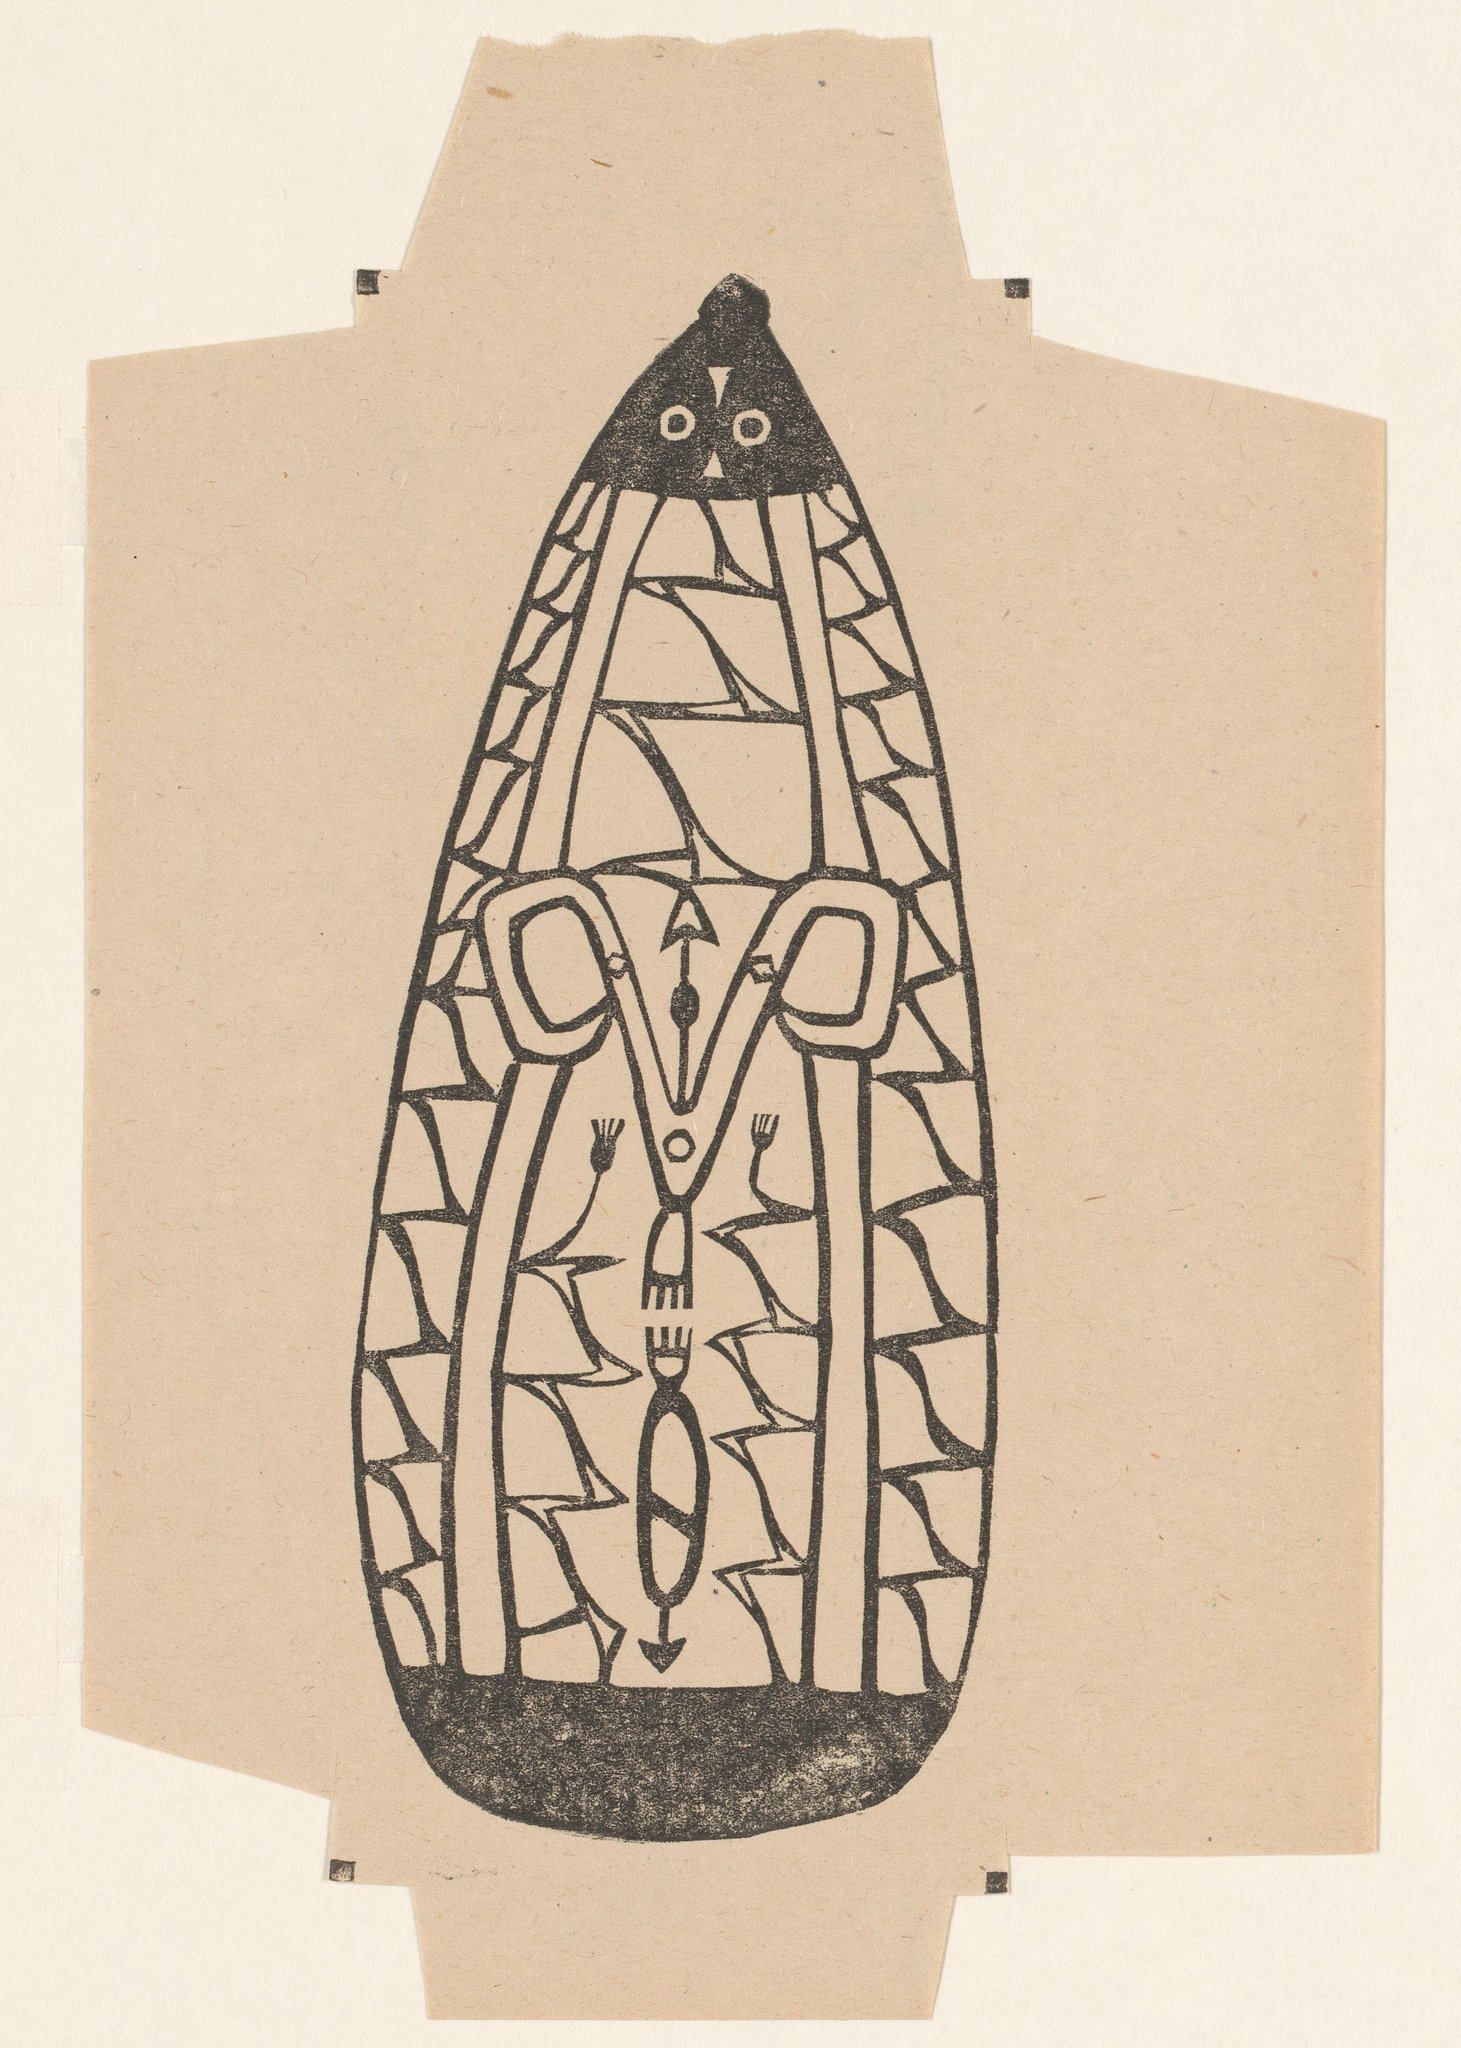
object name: print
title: Schild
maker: reijer stolk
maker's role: draughtsman, print maker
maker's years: 1896-1945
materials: paper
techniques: woodcut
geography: netherlands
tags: protective weapons: shield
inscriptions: collector's mark: Lugt 2228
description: Langwerpig schild met decoratief patroon. Op verso is een deel van een potloodtekening te zien.